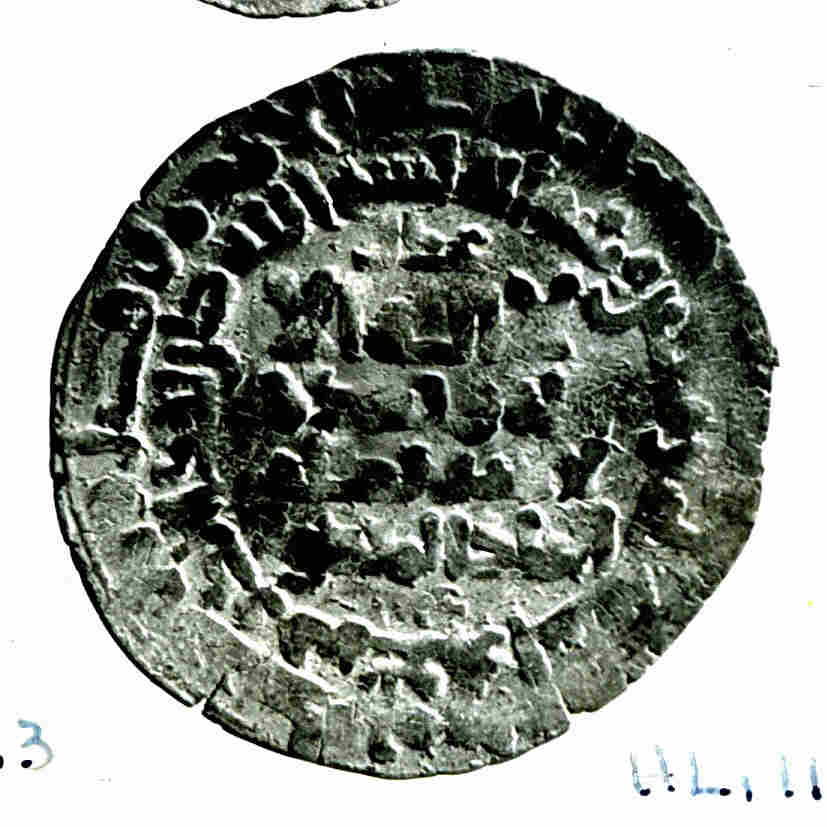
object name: coin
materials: silver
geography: uzbekistan